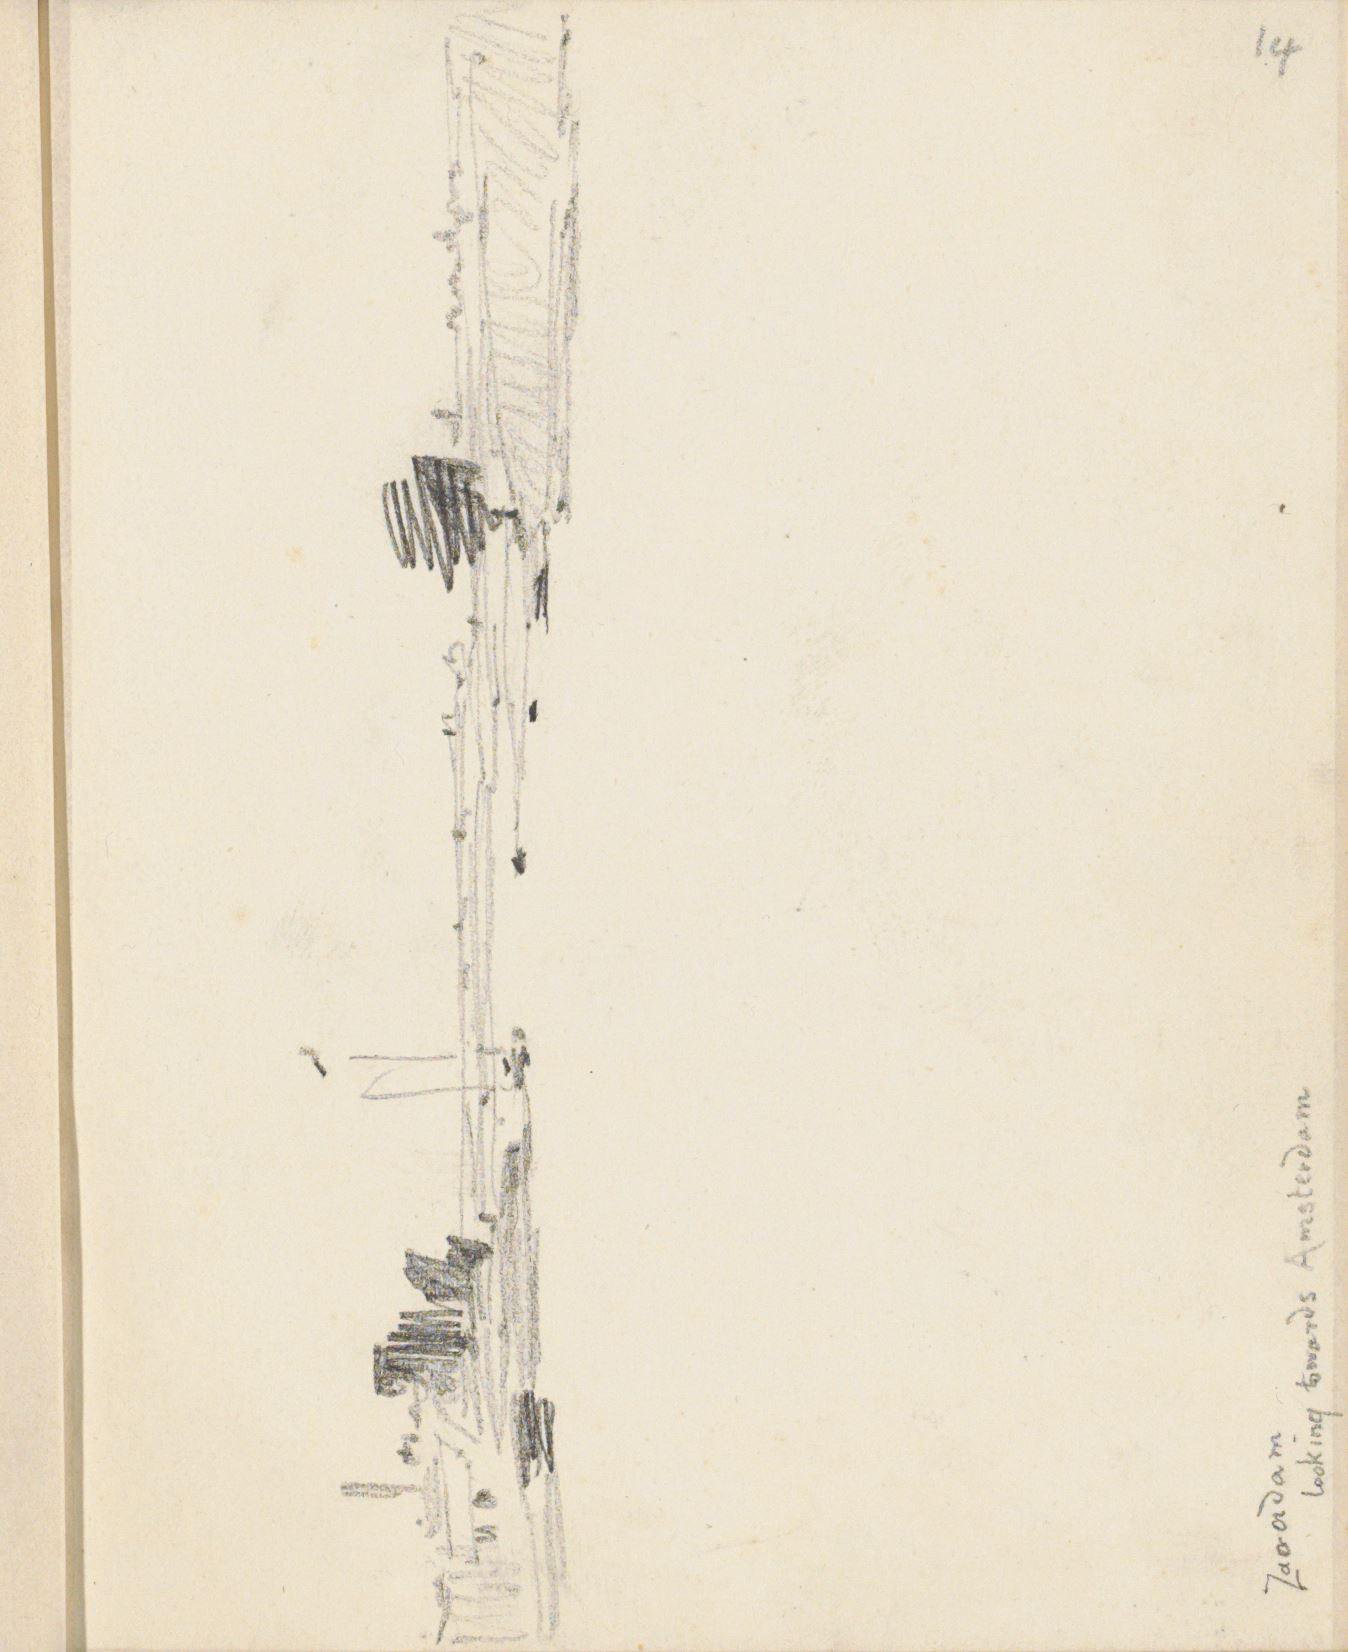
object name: sketchbook leaf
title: Gezicht op Zaandam in de richting van Amsterdam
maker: alfred william rich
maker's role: draughtsman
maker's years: 1856-1921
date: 1892-1893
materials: paper, pencil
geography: zaandam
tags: city-view, and landscape with man-made constructions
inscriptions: annotation: ‘Za[...]dam/ looking towards Amsterdam’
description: Blad 14 recto uit een schetsboek met 86 bladen.